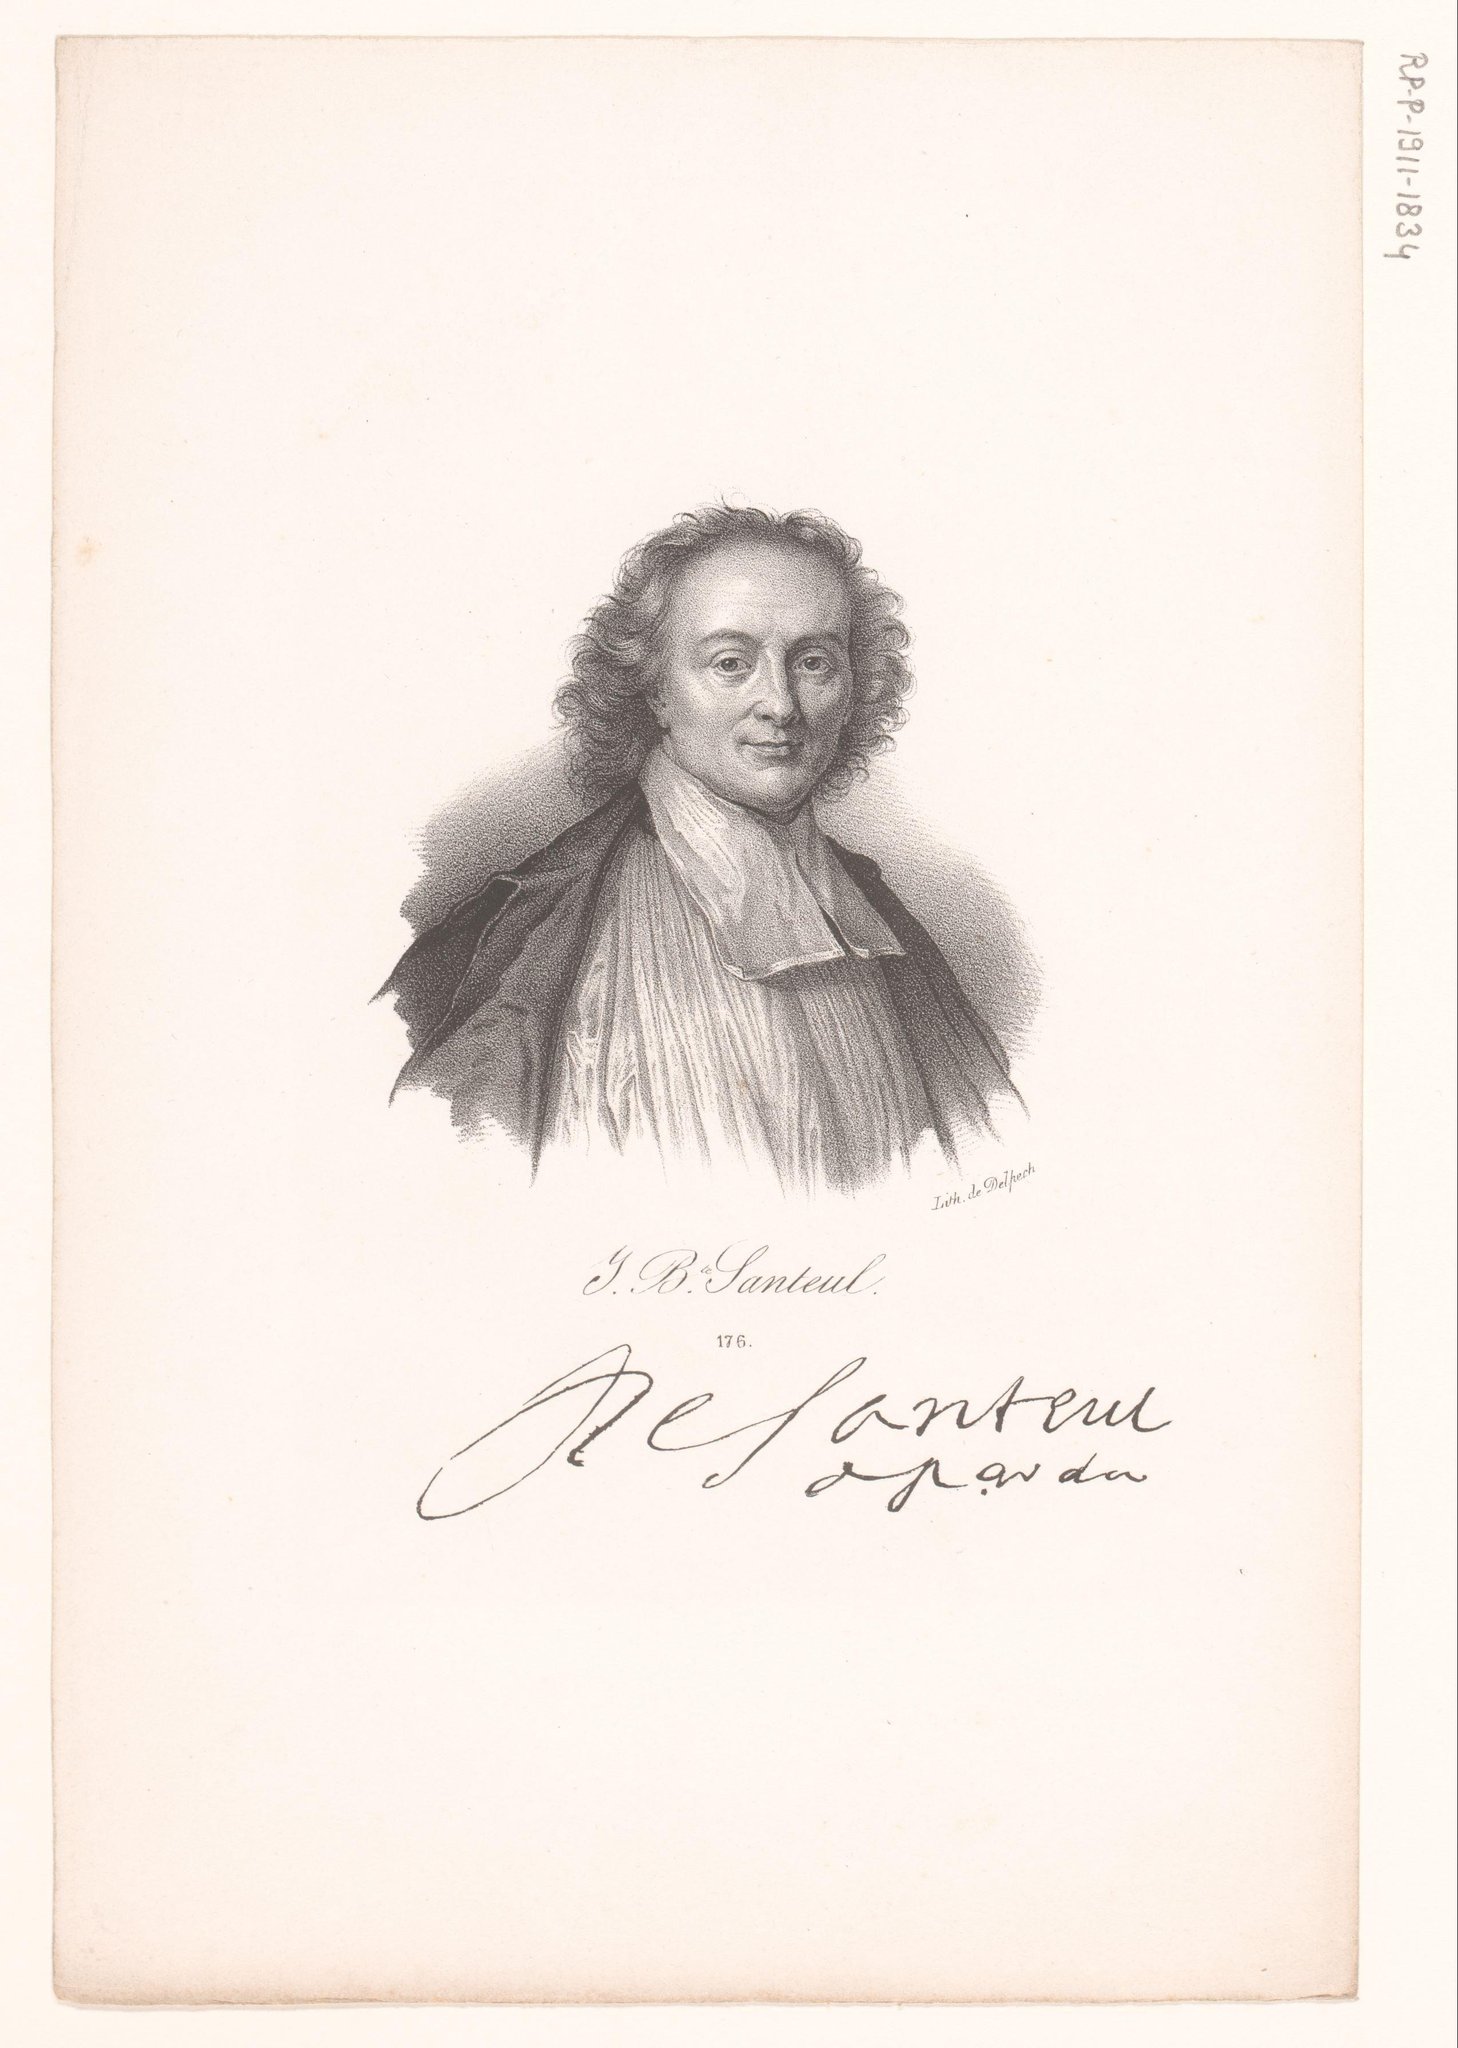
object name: print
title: J.B.te Santeul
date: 1818-1842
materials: paper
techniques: lithograph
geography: paris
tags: paris, jean de santeul, historical persons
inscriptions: collector's mark: Lugt 2228a